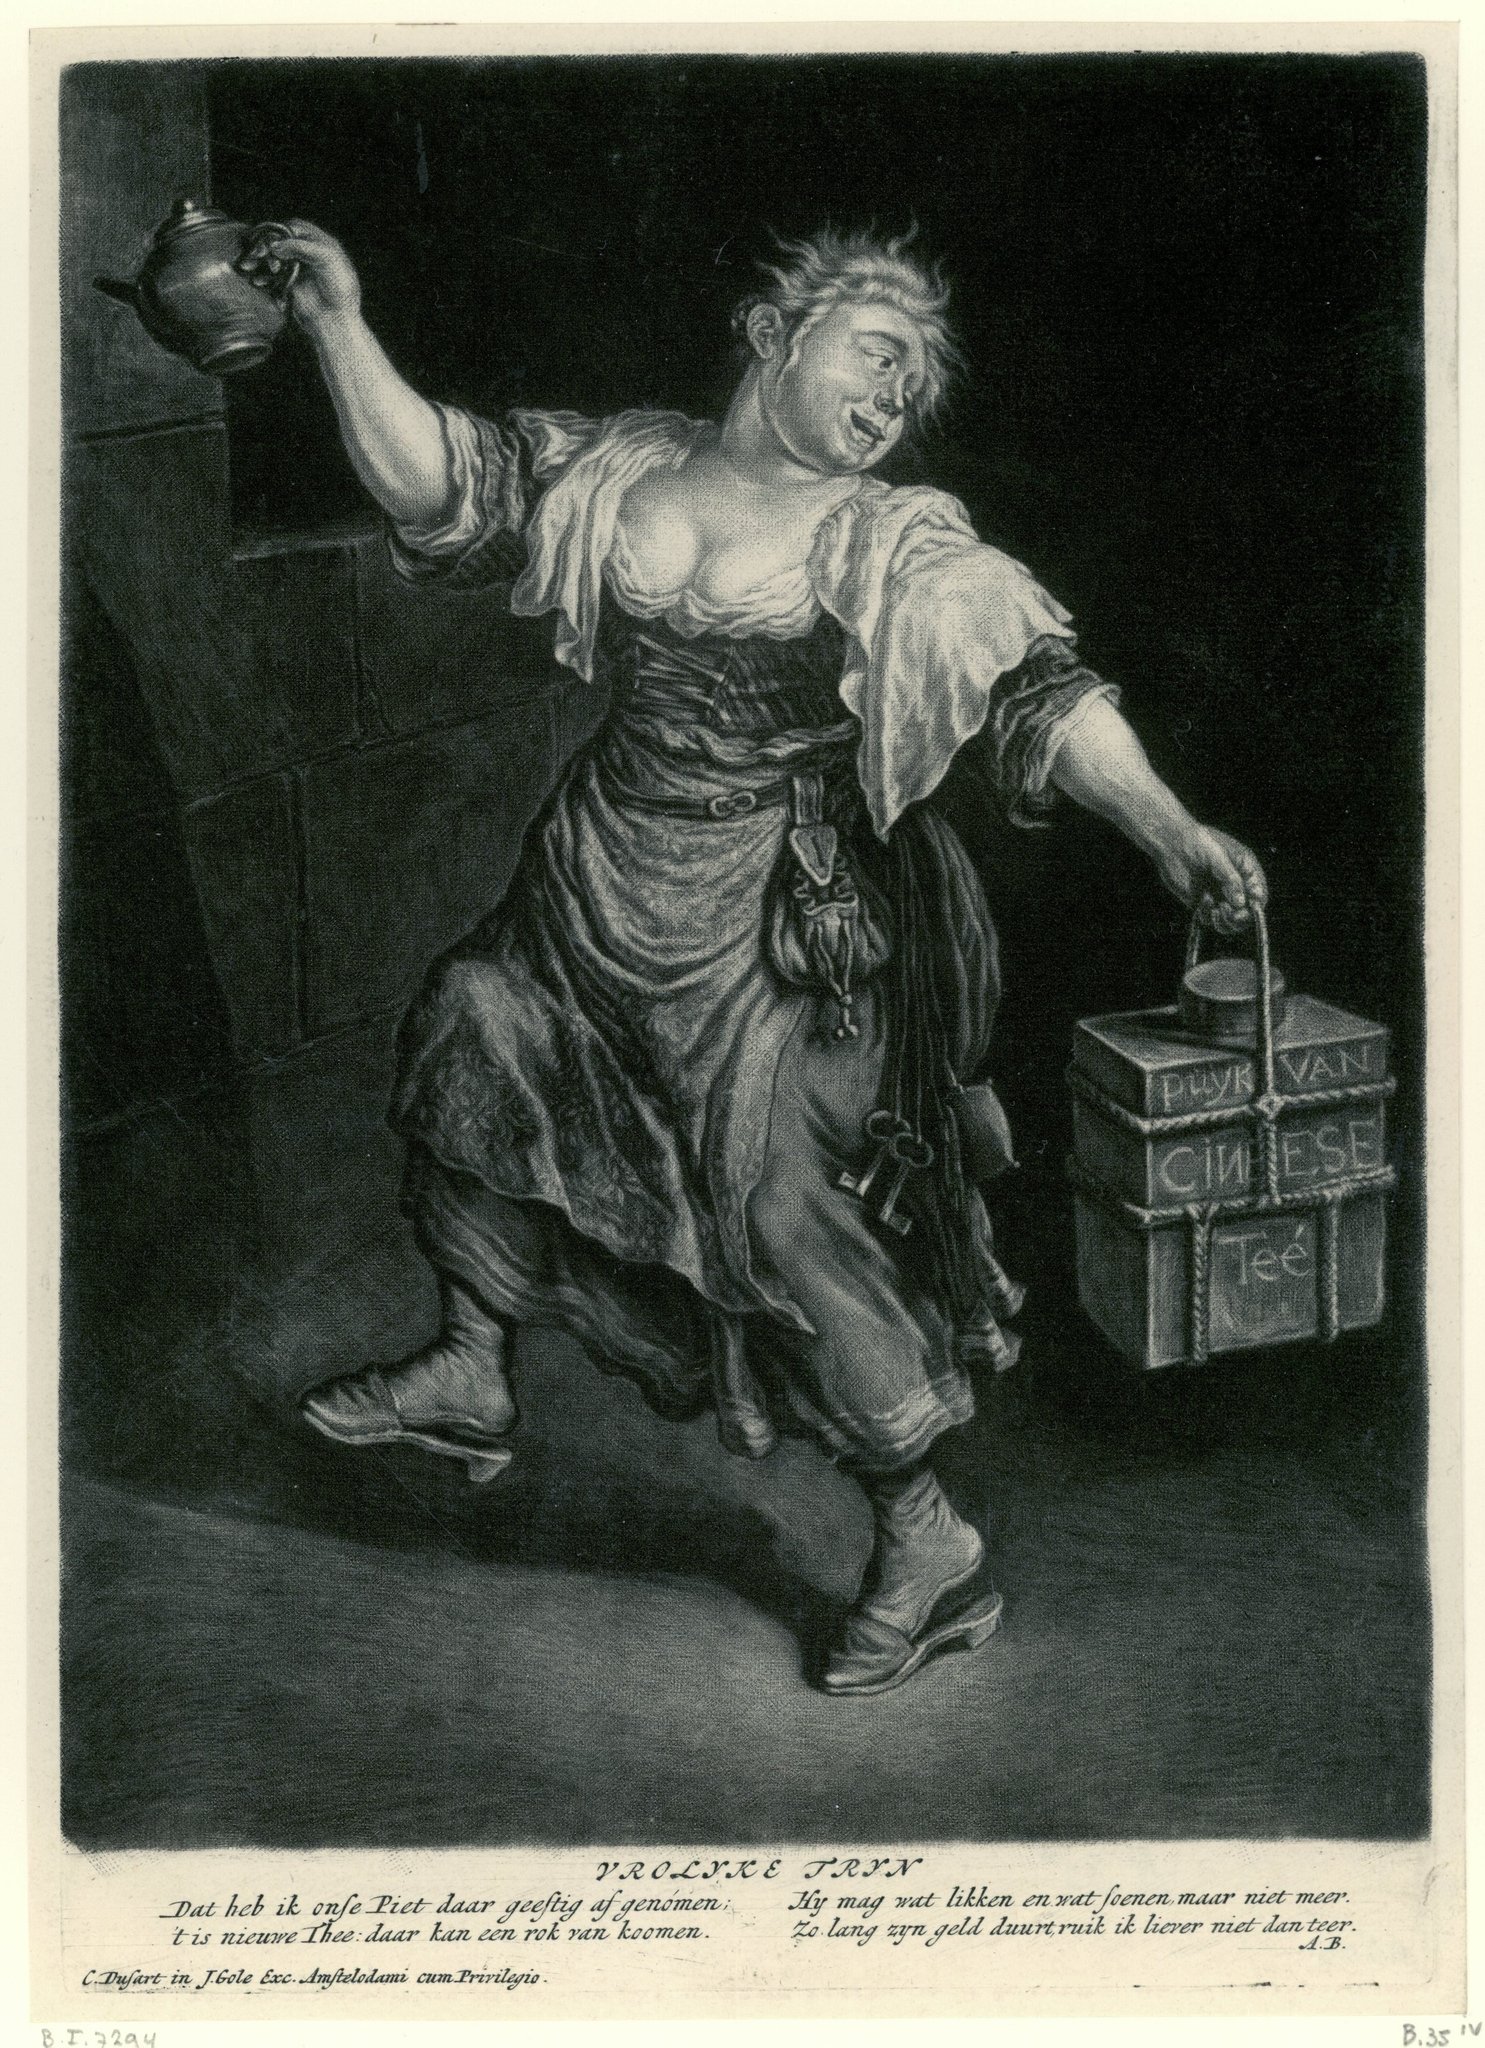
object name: print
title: Vrolyke Tryn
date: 1695-1704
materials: paper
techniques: engraving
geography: amsterdam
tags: the hague, william iii (prince of orange and king of england, scotland, and ireland), festivities on events of national importance, tea (leaves)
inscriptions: collector's mark: Lugt 240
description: Een dansende theeverkoopster, met in de hand een pot thee. Wellicht heeft deze voorstelling betrekking op de Vrede van Rijswijk in 1697. De prent is onderdeel van een reeks van acht prenten vervaardigd naar aanleiding van de verovering van Namen door de geallieerden op 5 september 1695.